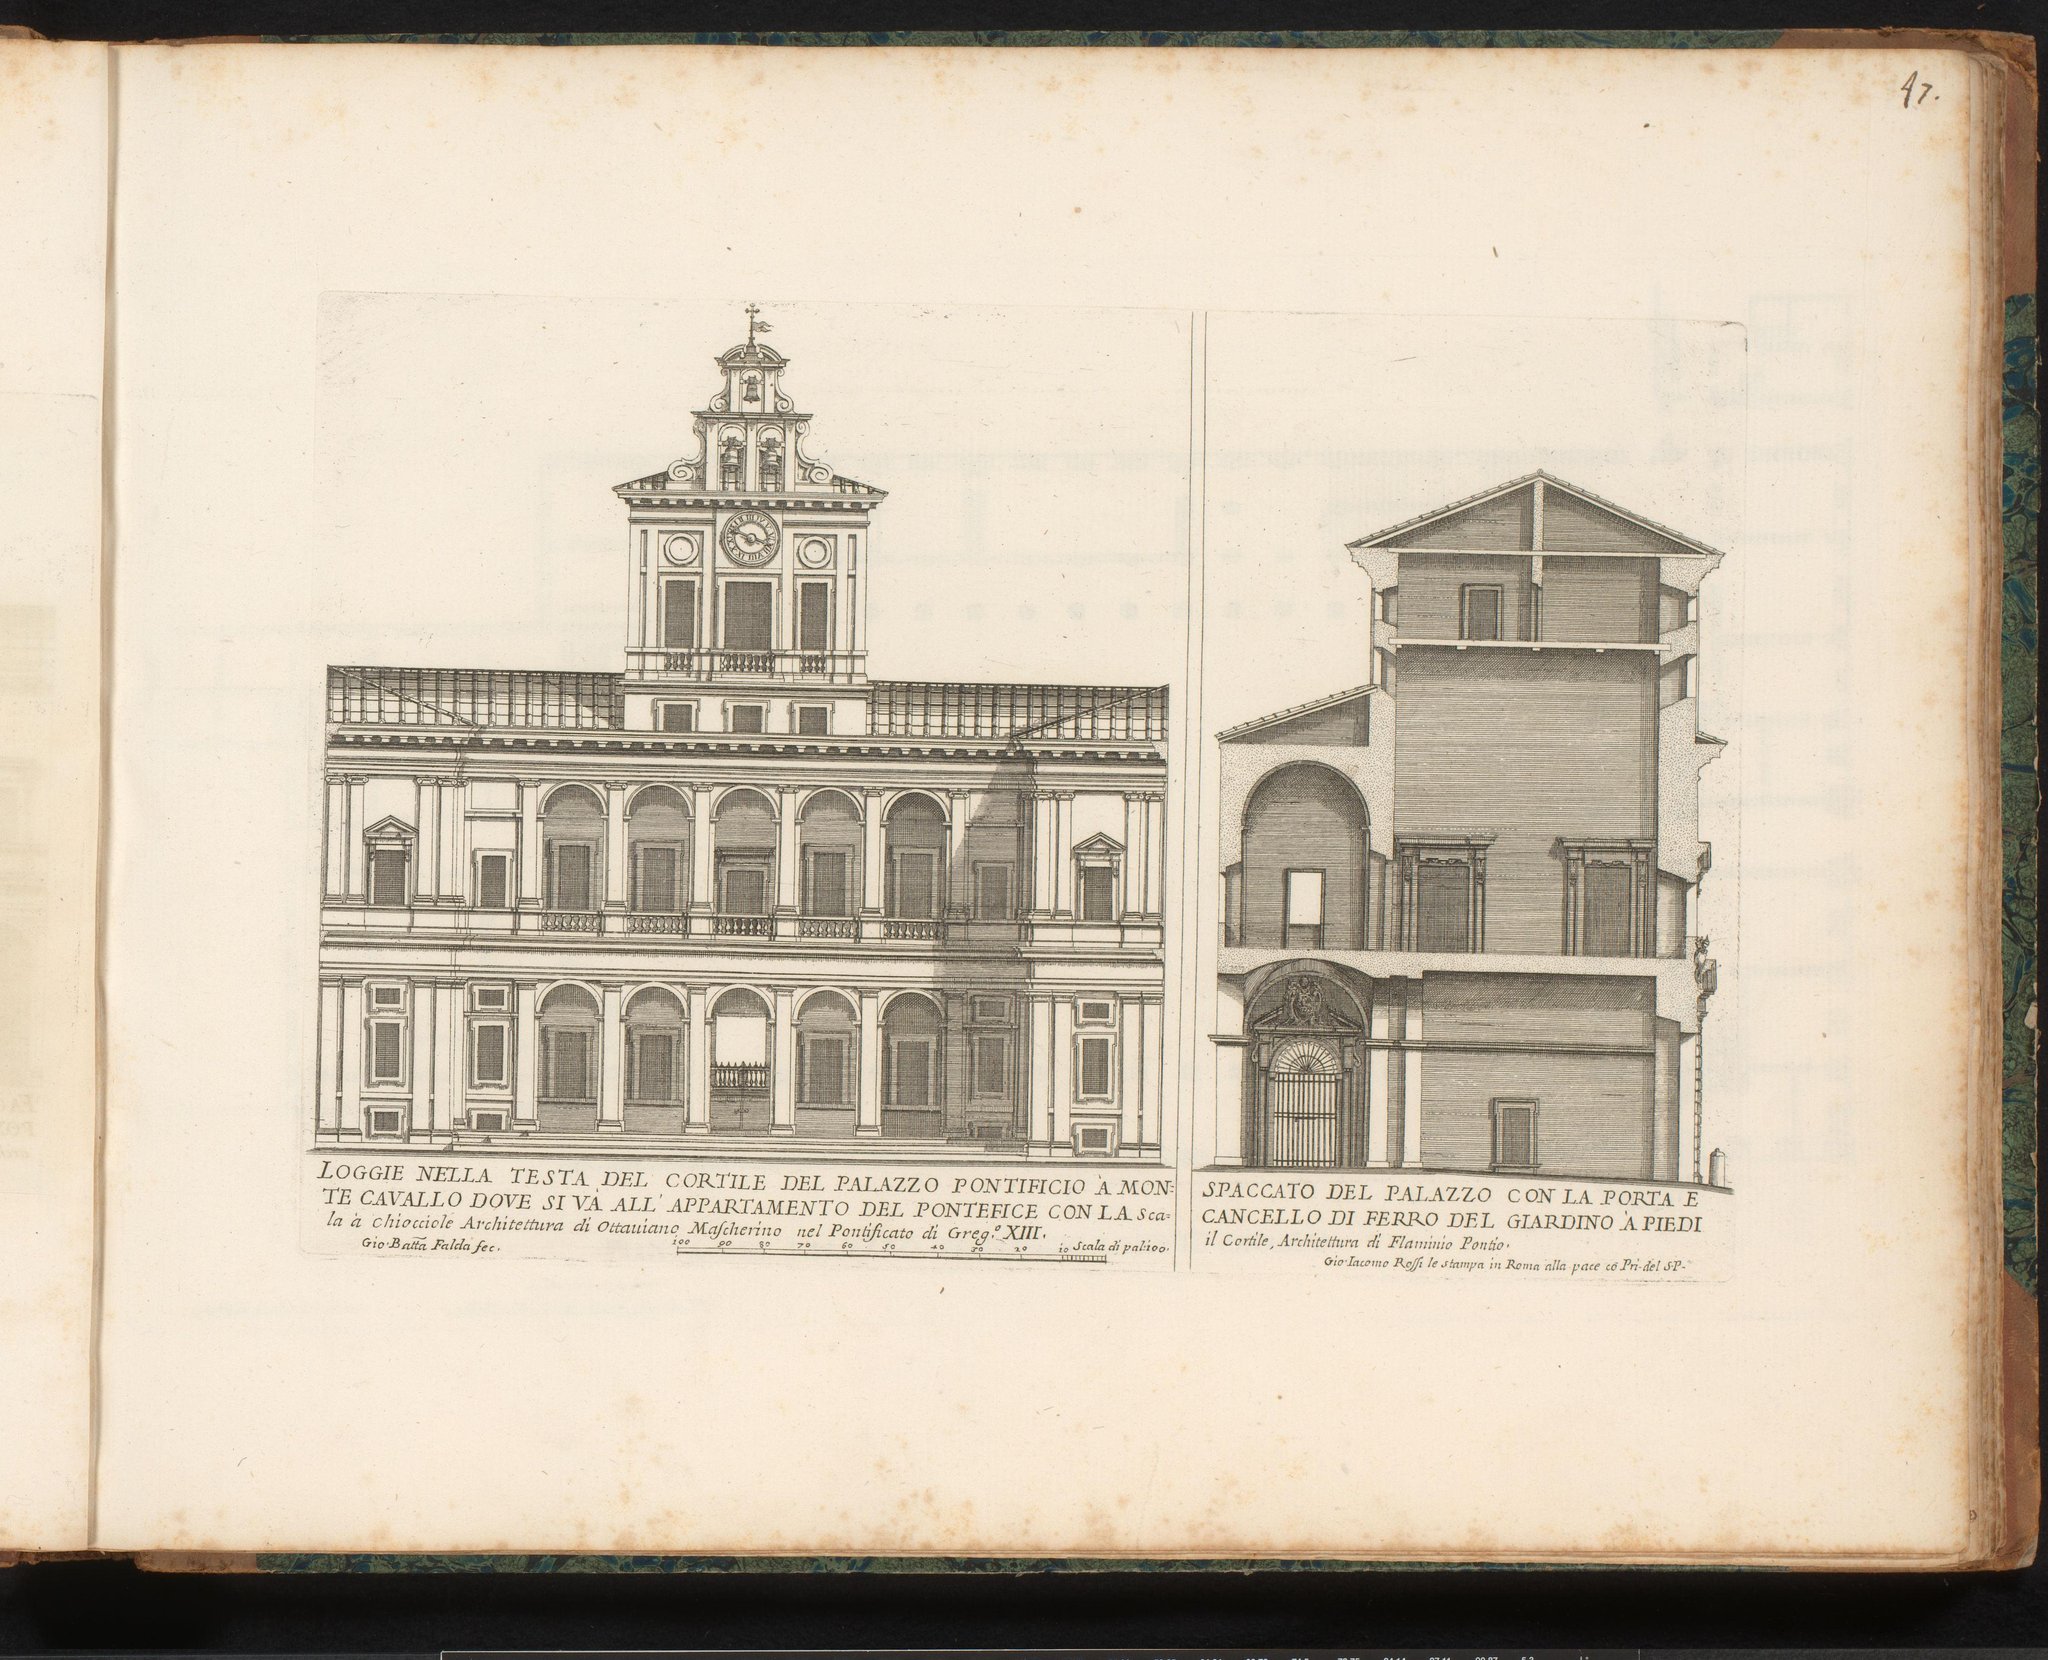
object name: print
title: Palazzi di Roma dei più celebri architett (...)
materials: paper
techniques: etching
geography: rome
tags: rome, gregorius xiii, palace, façade (of house or building), inner court of palace or 'hôtel'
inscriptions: number: ‘47’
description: Deze prent maakt deel uit van de reeks getiteld: Palazzi di Roma. Deze reeks bestaat uit twee boeken. Boek één getiteld: Palazzi di Roma dei più celebri architetti..., bestaat uit 44 prenten die worden toegeschreven aan Giovanni Battista Falda (naam staat enkel op prent 27) en uitgegeven door Giovanni Giacomo de'Rossi. Deze 44 prenten zijn bekend in twee staten (met en zonder nummer). Boek twee getiteld: Nuovi disegni dell'architetture... libro secondo, bevat 66 prenten door Giovanni Battista Falda en Simone Felice. Deze 66 prenten zijn bekend in twee staten (met en zonder nummer).